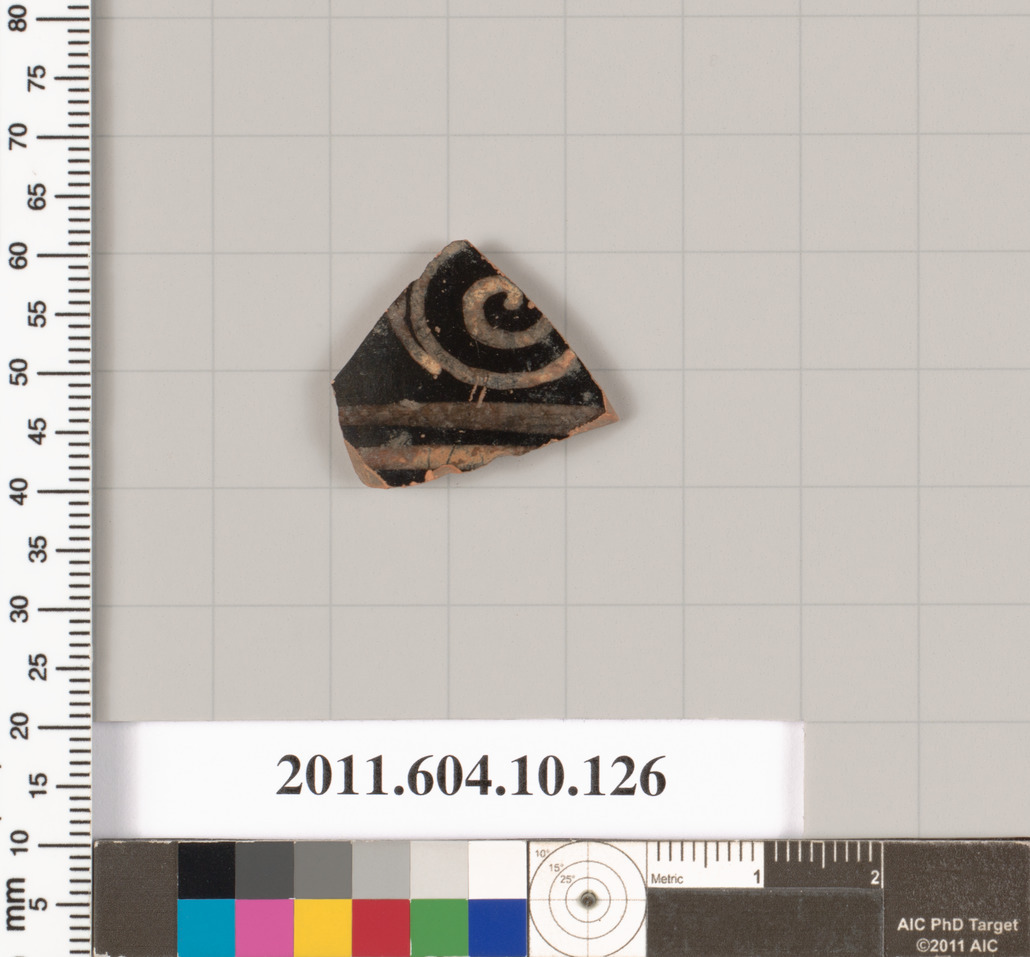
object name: undetermined closed shape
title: Terracotta fragment of a closed shape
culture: etruscan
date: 434-401 BCE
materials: terracotta